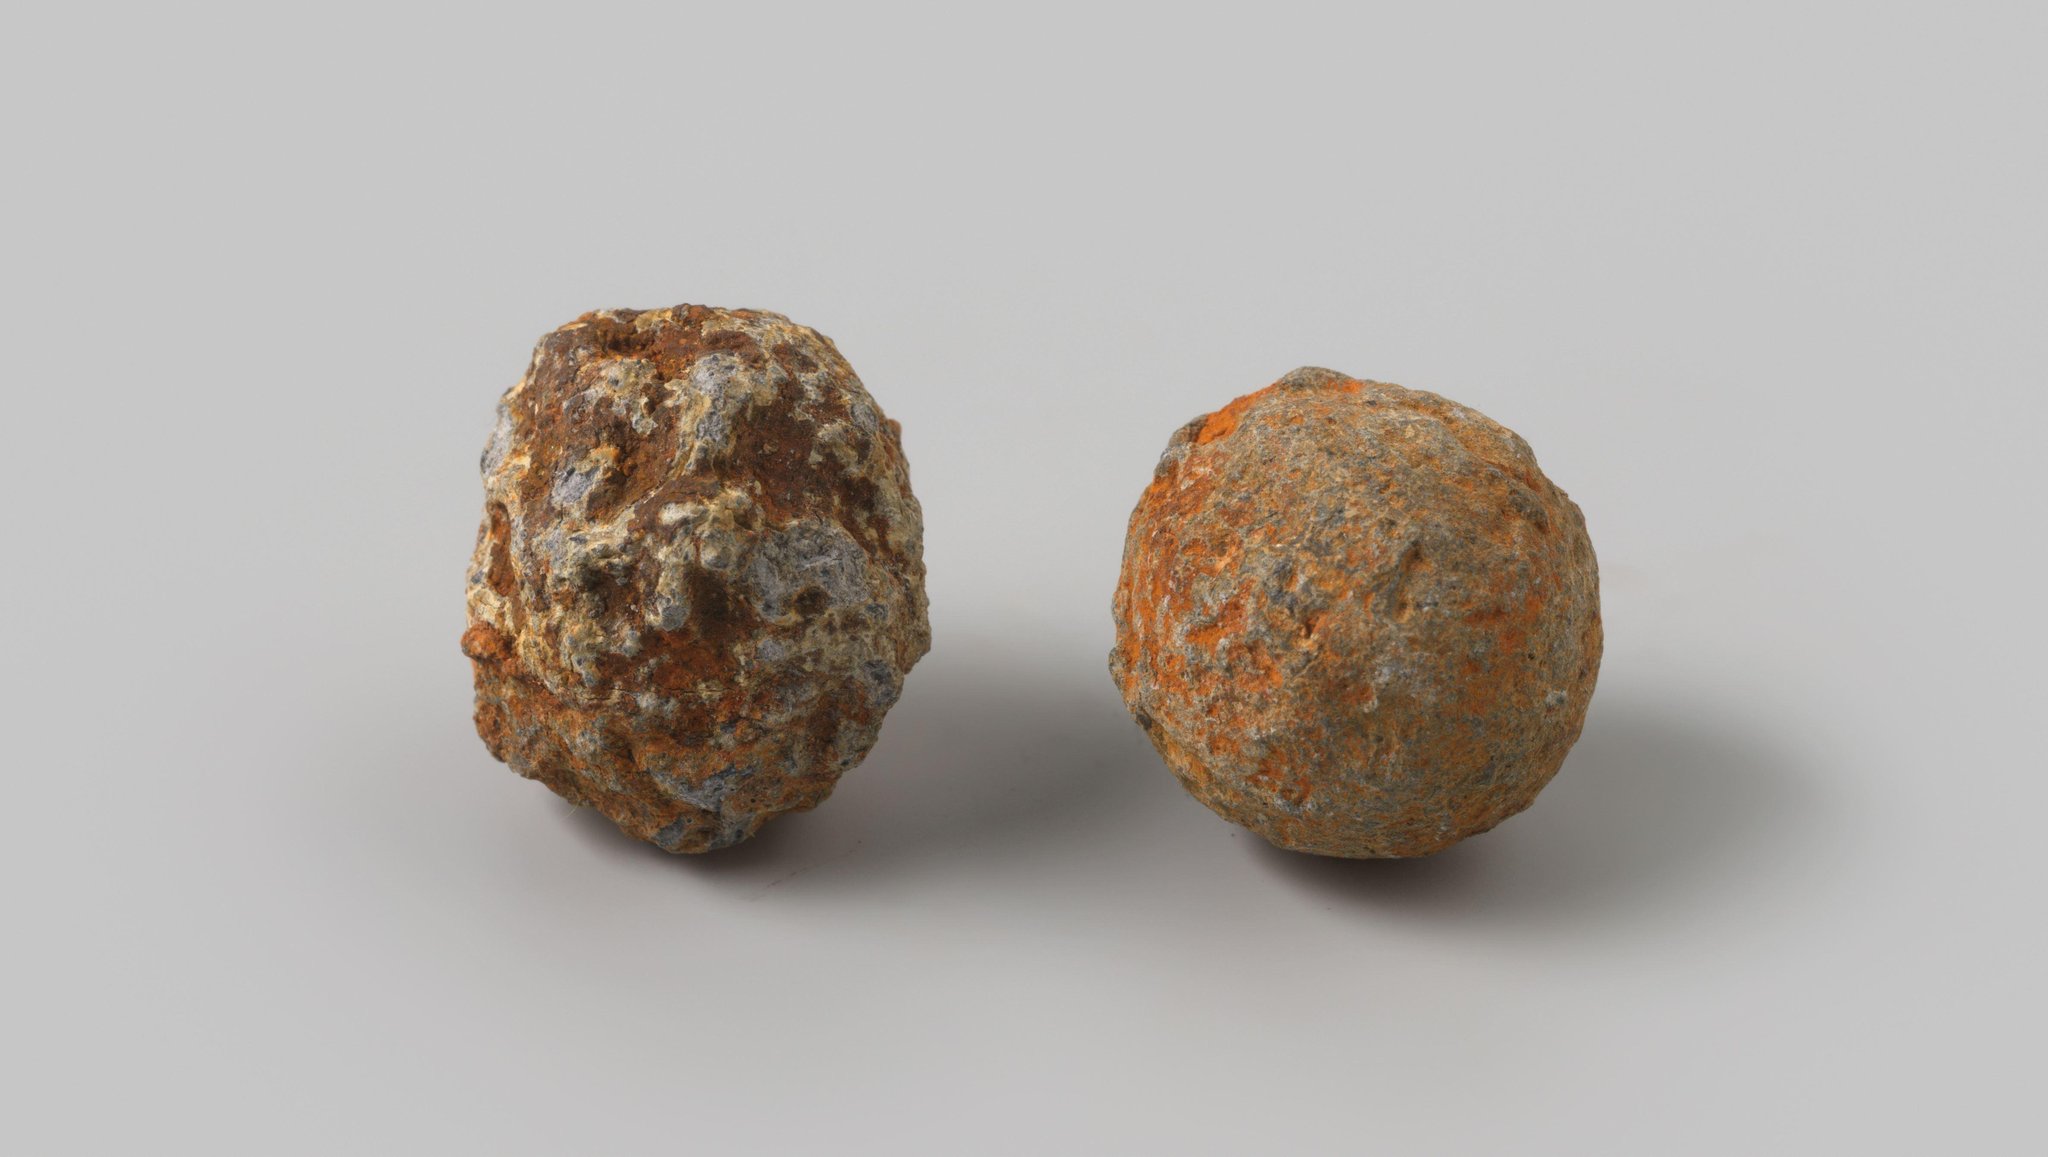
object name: musketkogel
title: Musketkogels uit het wrak van de Oost-Indiëvaarder Hollandia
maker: Anonymous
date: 1700-1743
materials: lead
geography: netherlands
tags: verenigde oostindische compagnie, hollandia (schip), annet